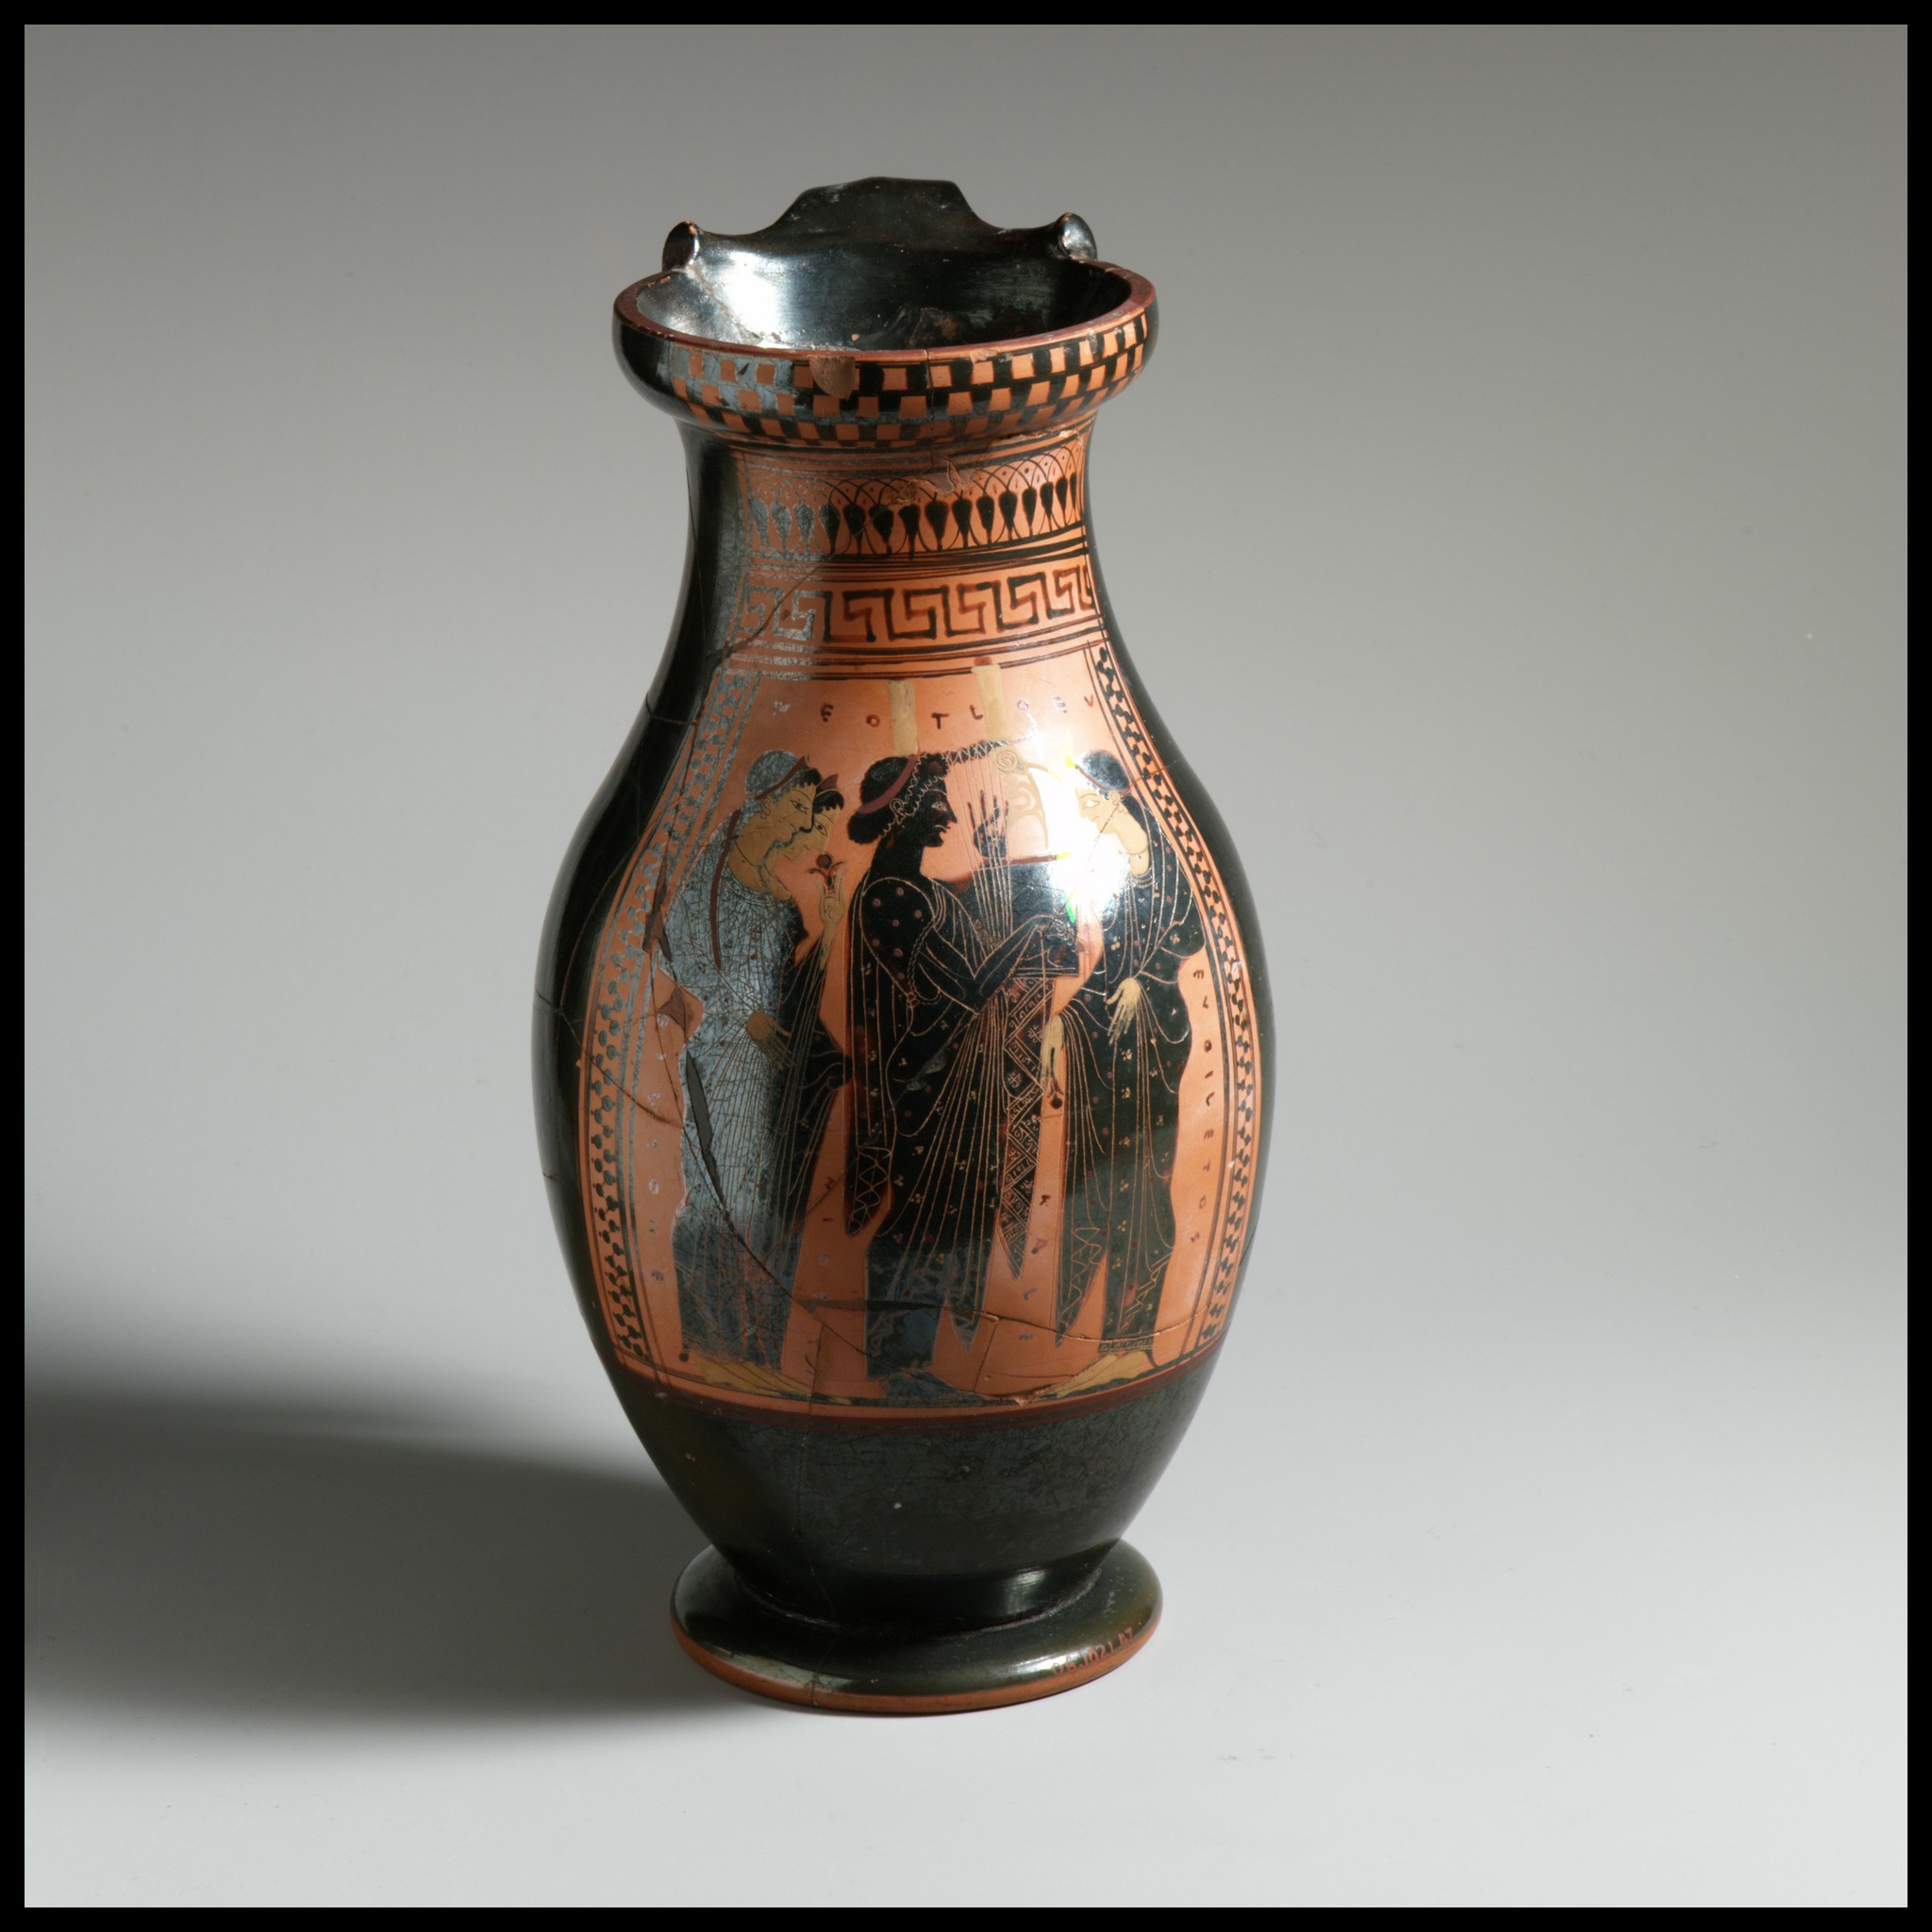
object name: olpe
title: Terracotta oinochoe: olpe (round-mouthed jug)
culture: greek, attic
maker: euphiletos painter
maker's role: artist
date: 520 BCE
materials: terracotta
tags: apollo,muses,lyres